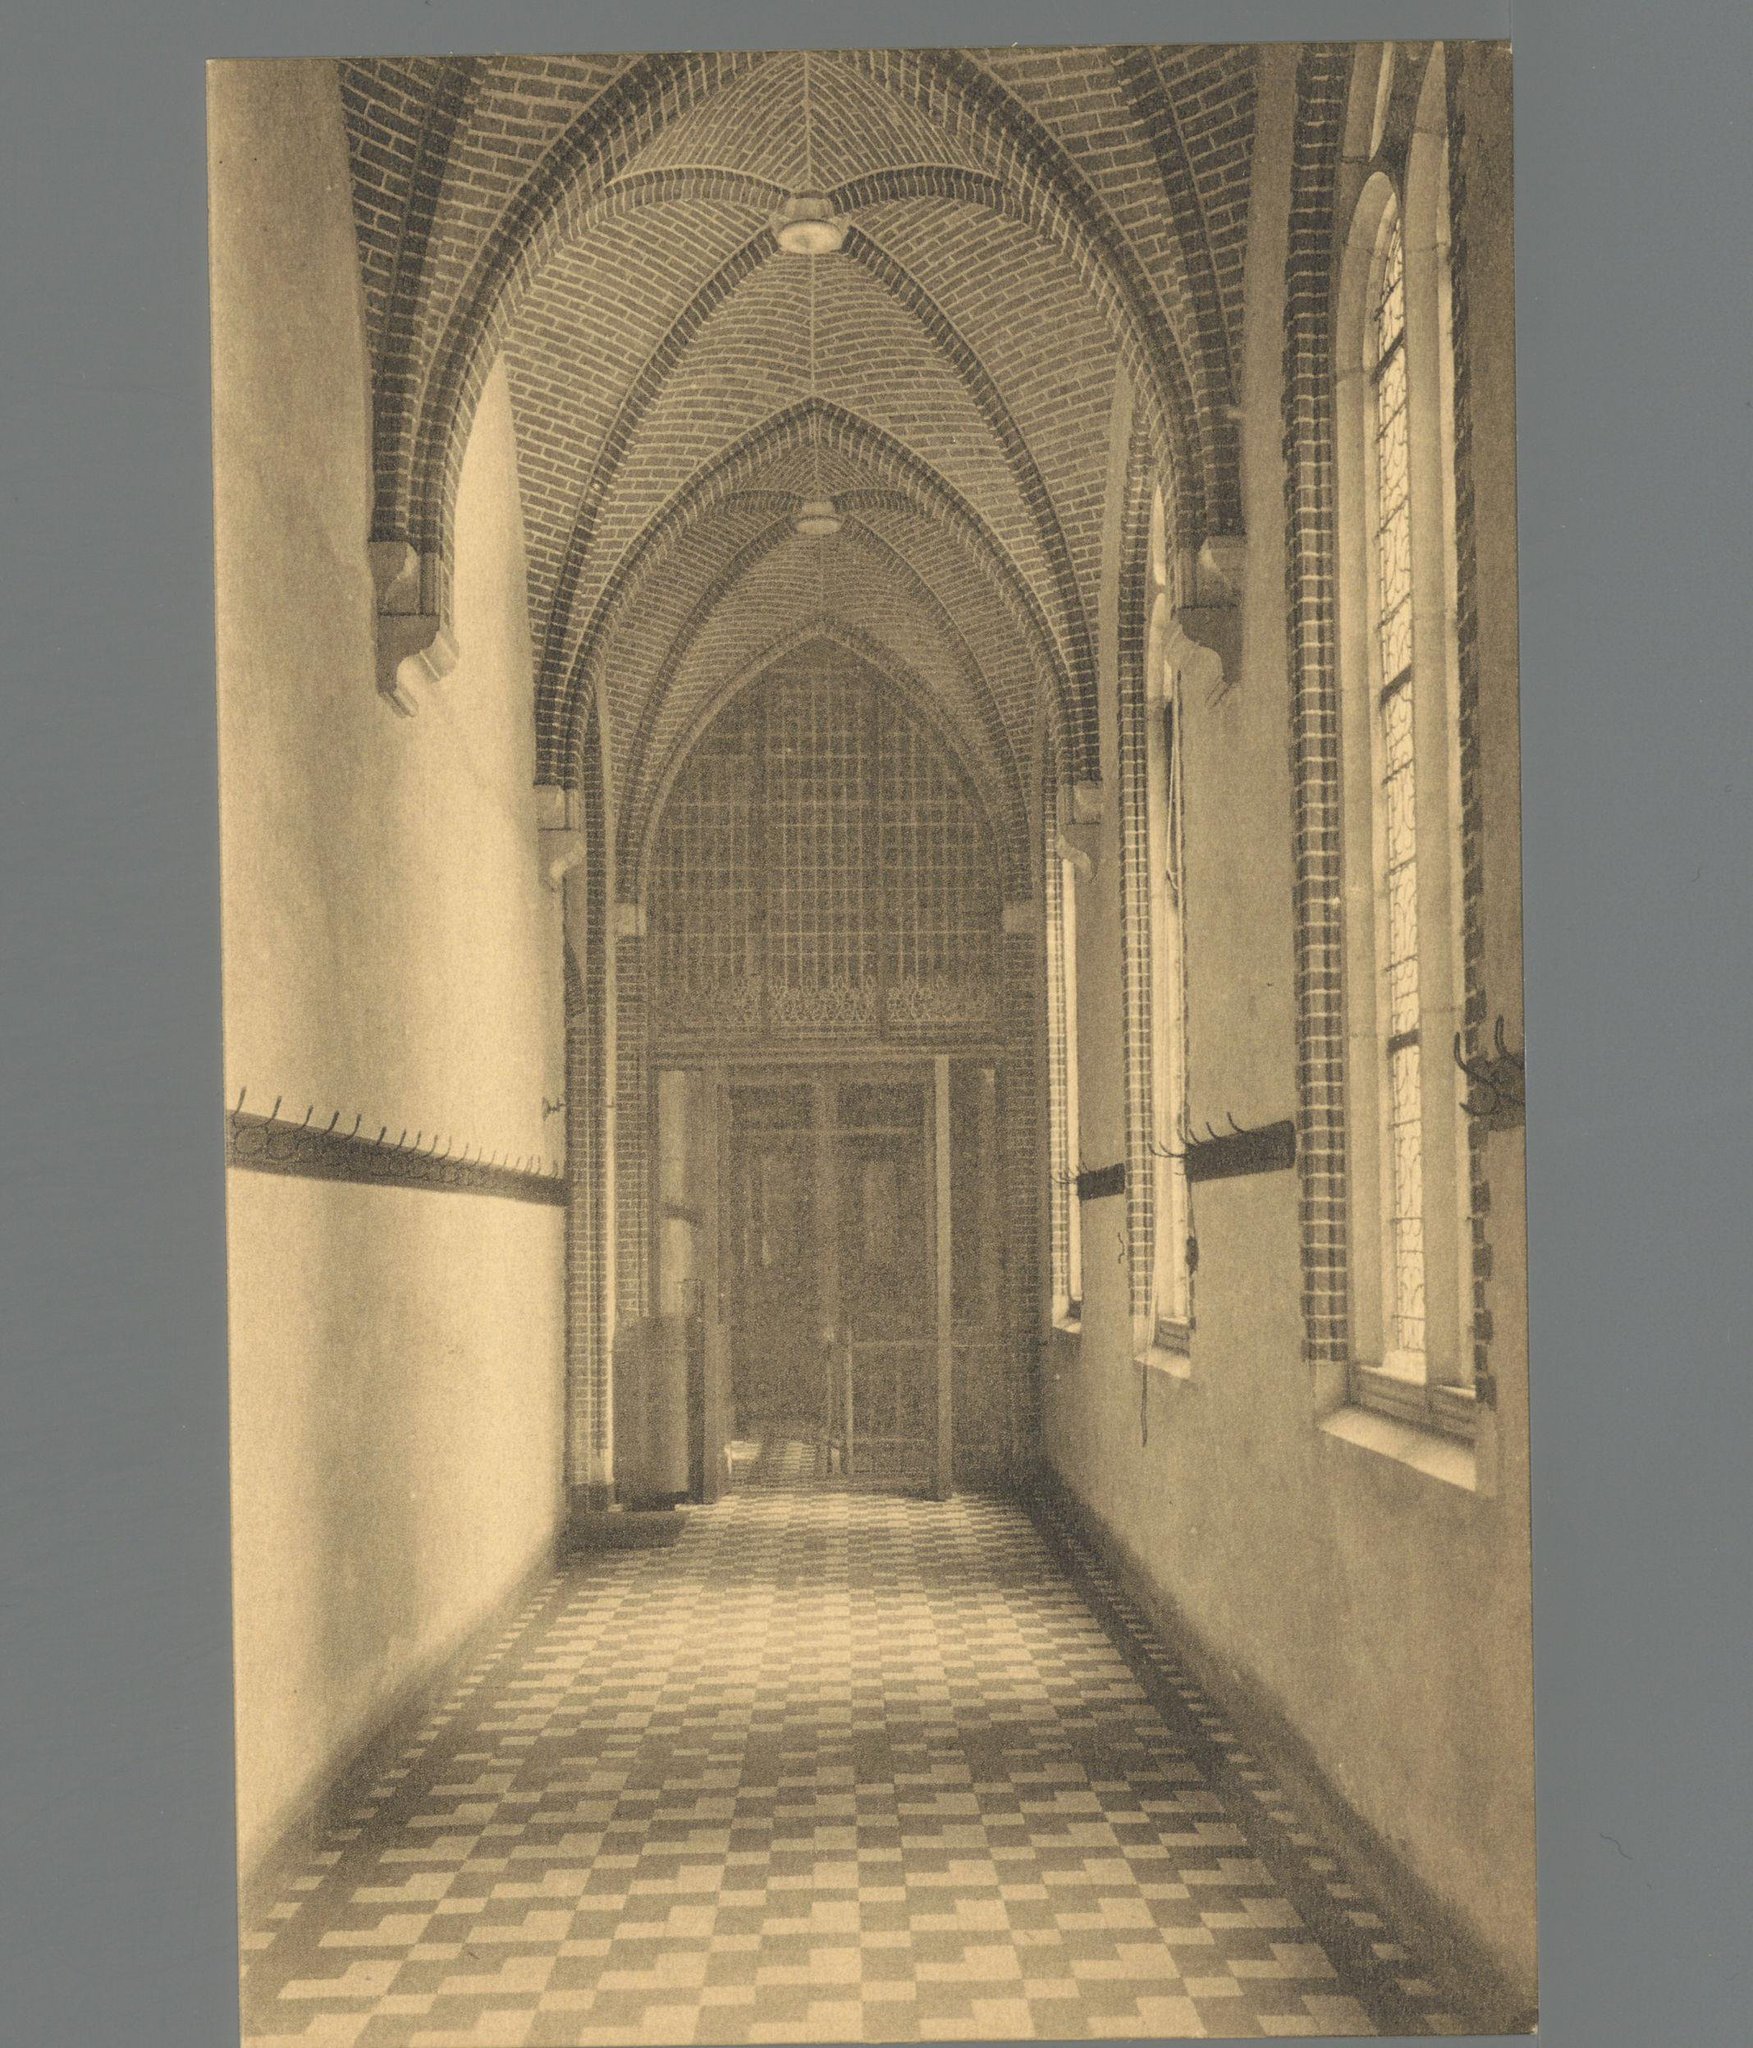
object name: photomechanical print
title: Leiden. Benedengang Nieuwe Gebouw. Rapenburg No. 25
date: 1905-1930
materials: cardboard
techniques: photograph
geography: leiden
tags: gallery (spacious corridor), university building, college, leiden